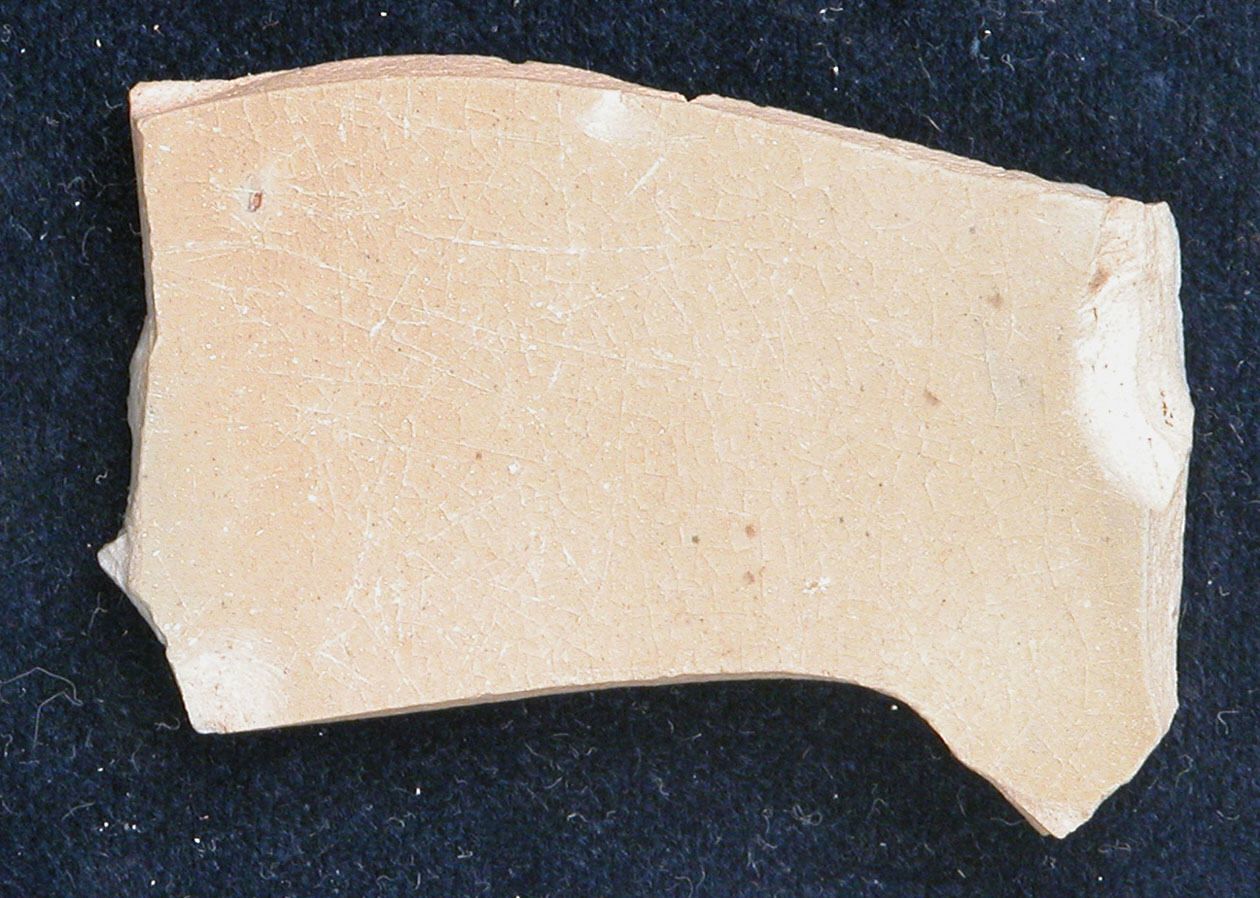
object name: fragment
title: Ceramic Fragment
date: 1101-1300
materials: stonepaste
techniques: glazing, painting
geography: saudi arabia